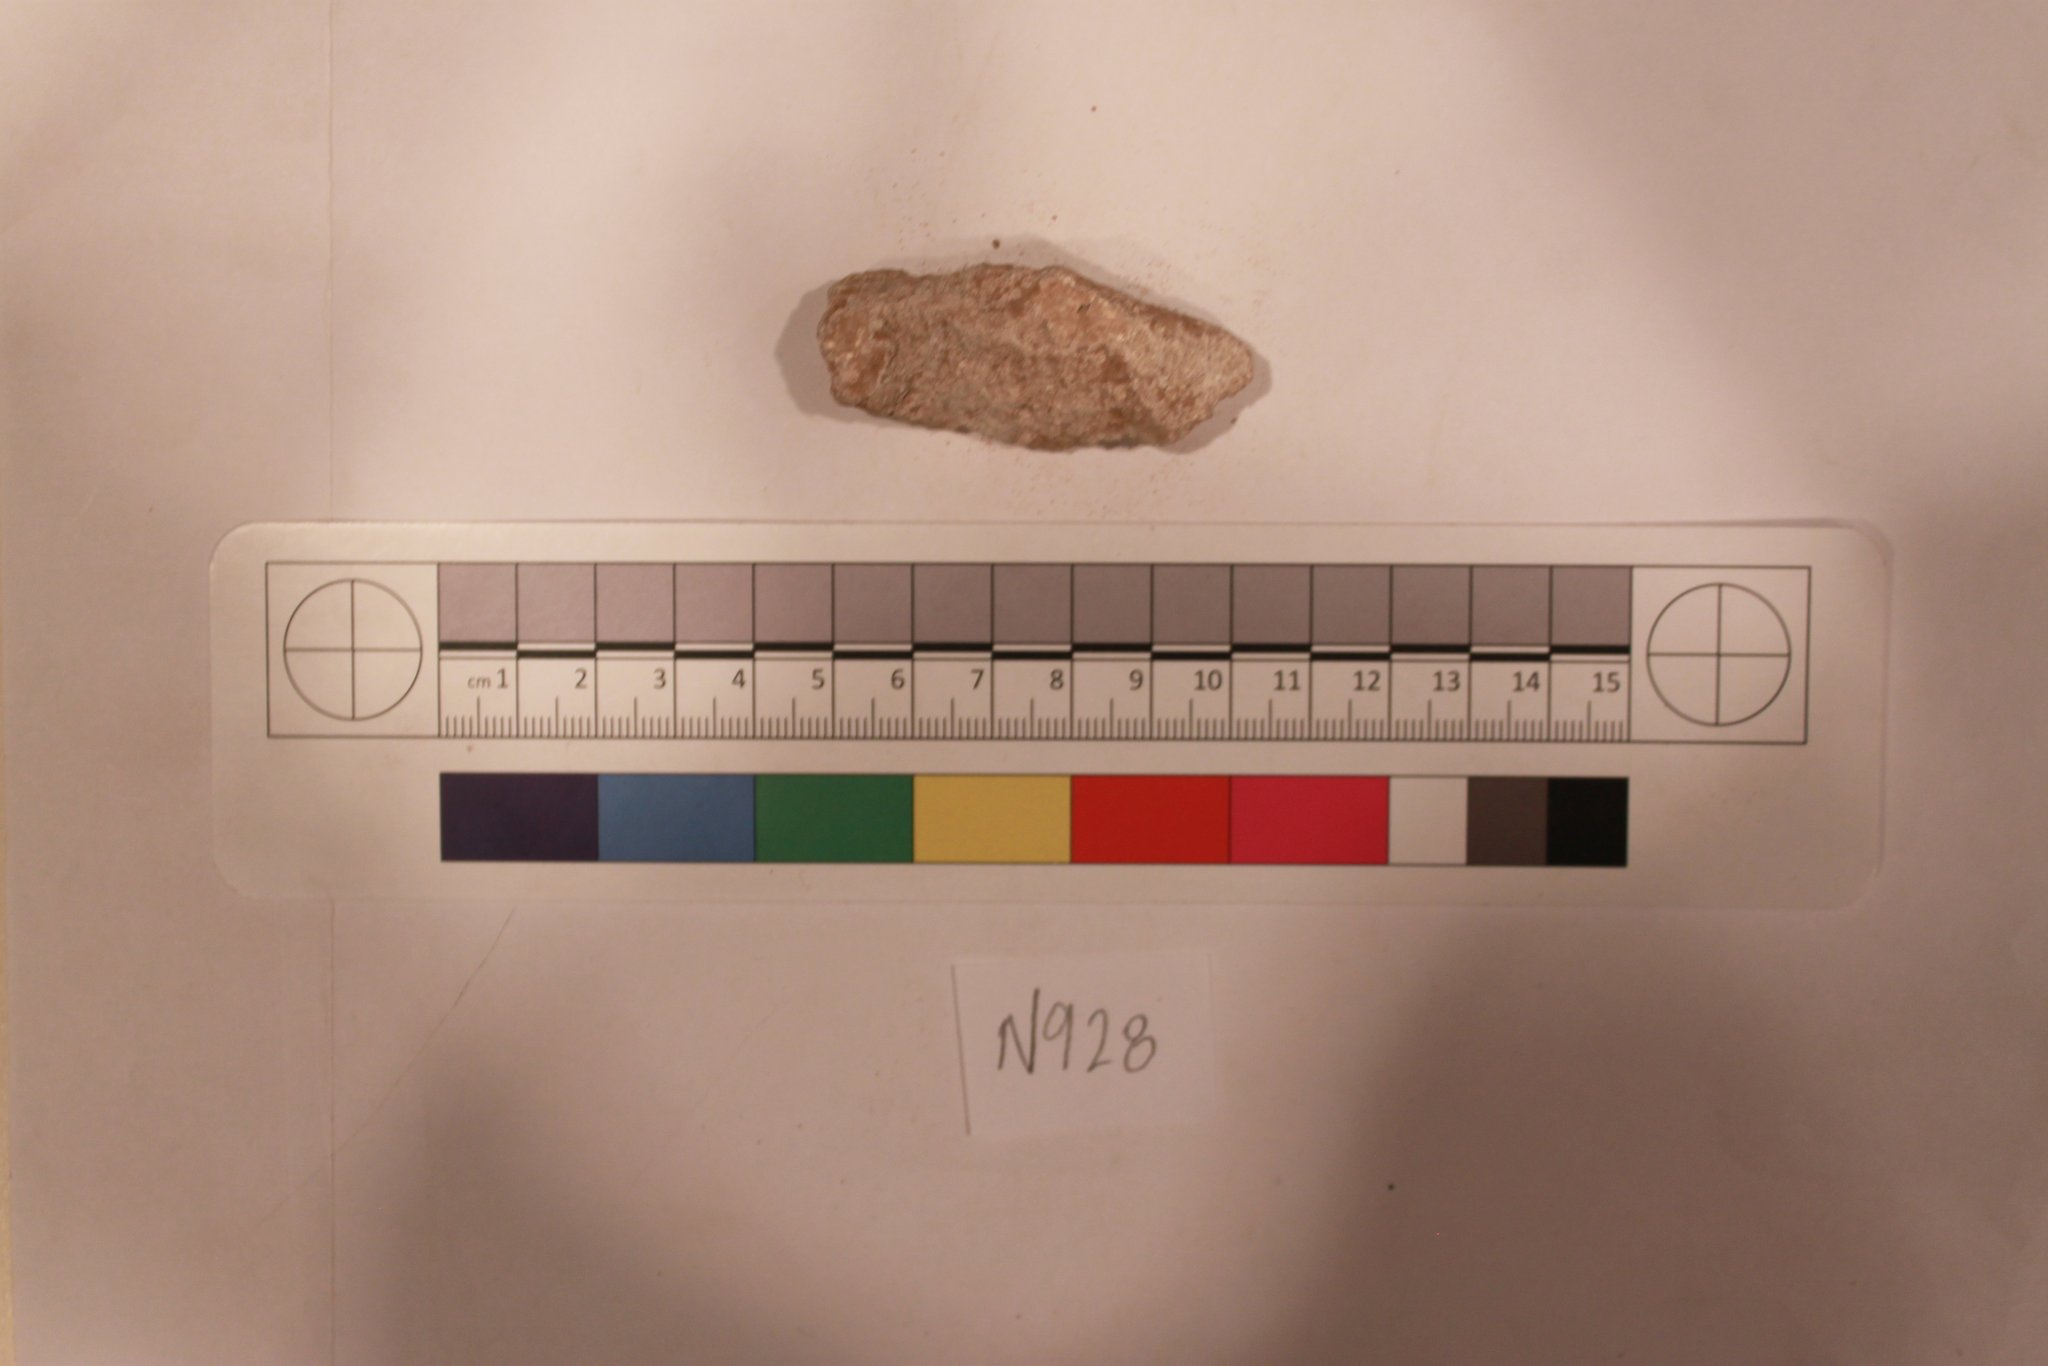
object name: fragment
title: Stucco Fragment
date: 701-1200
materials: plaster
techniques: carving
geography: iran